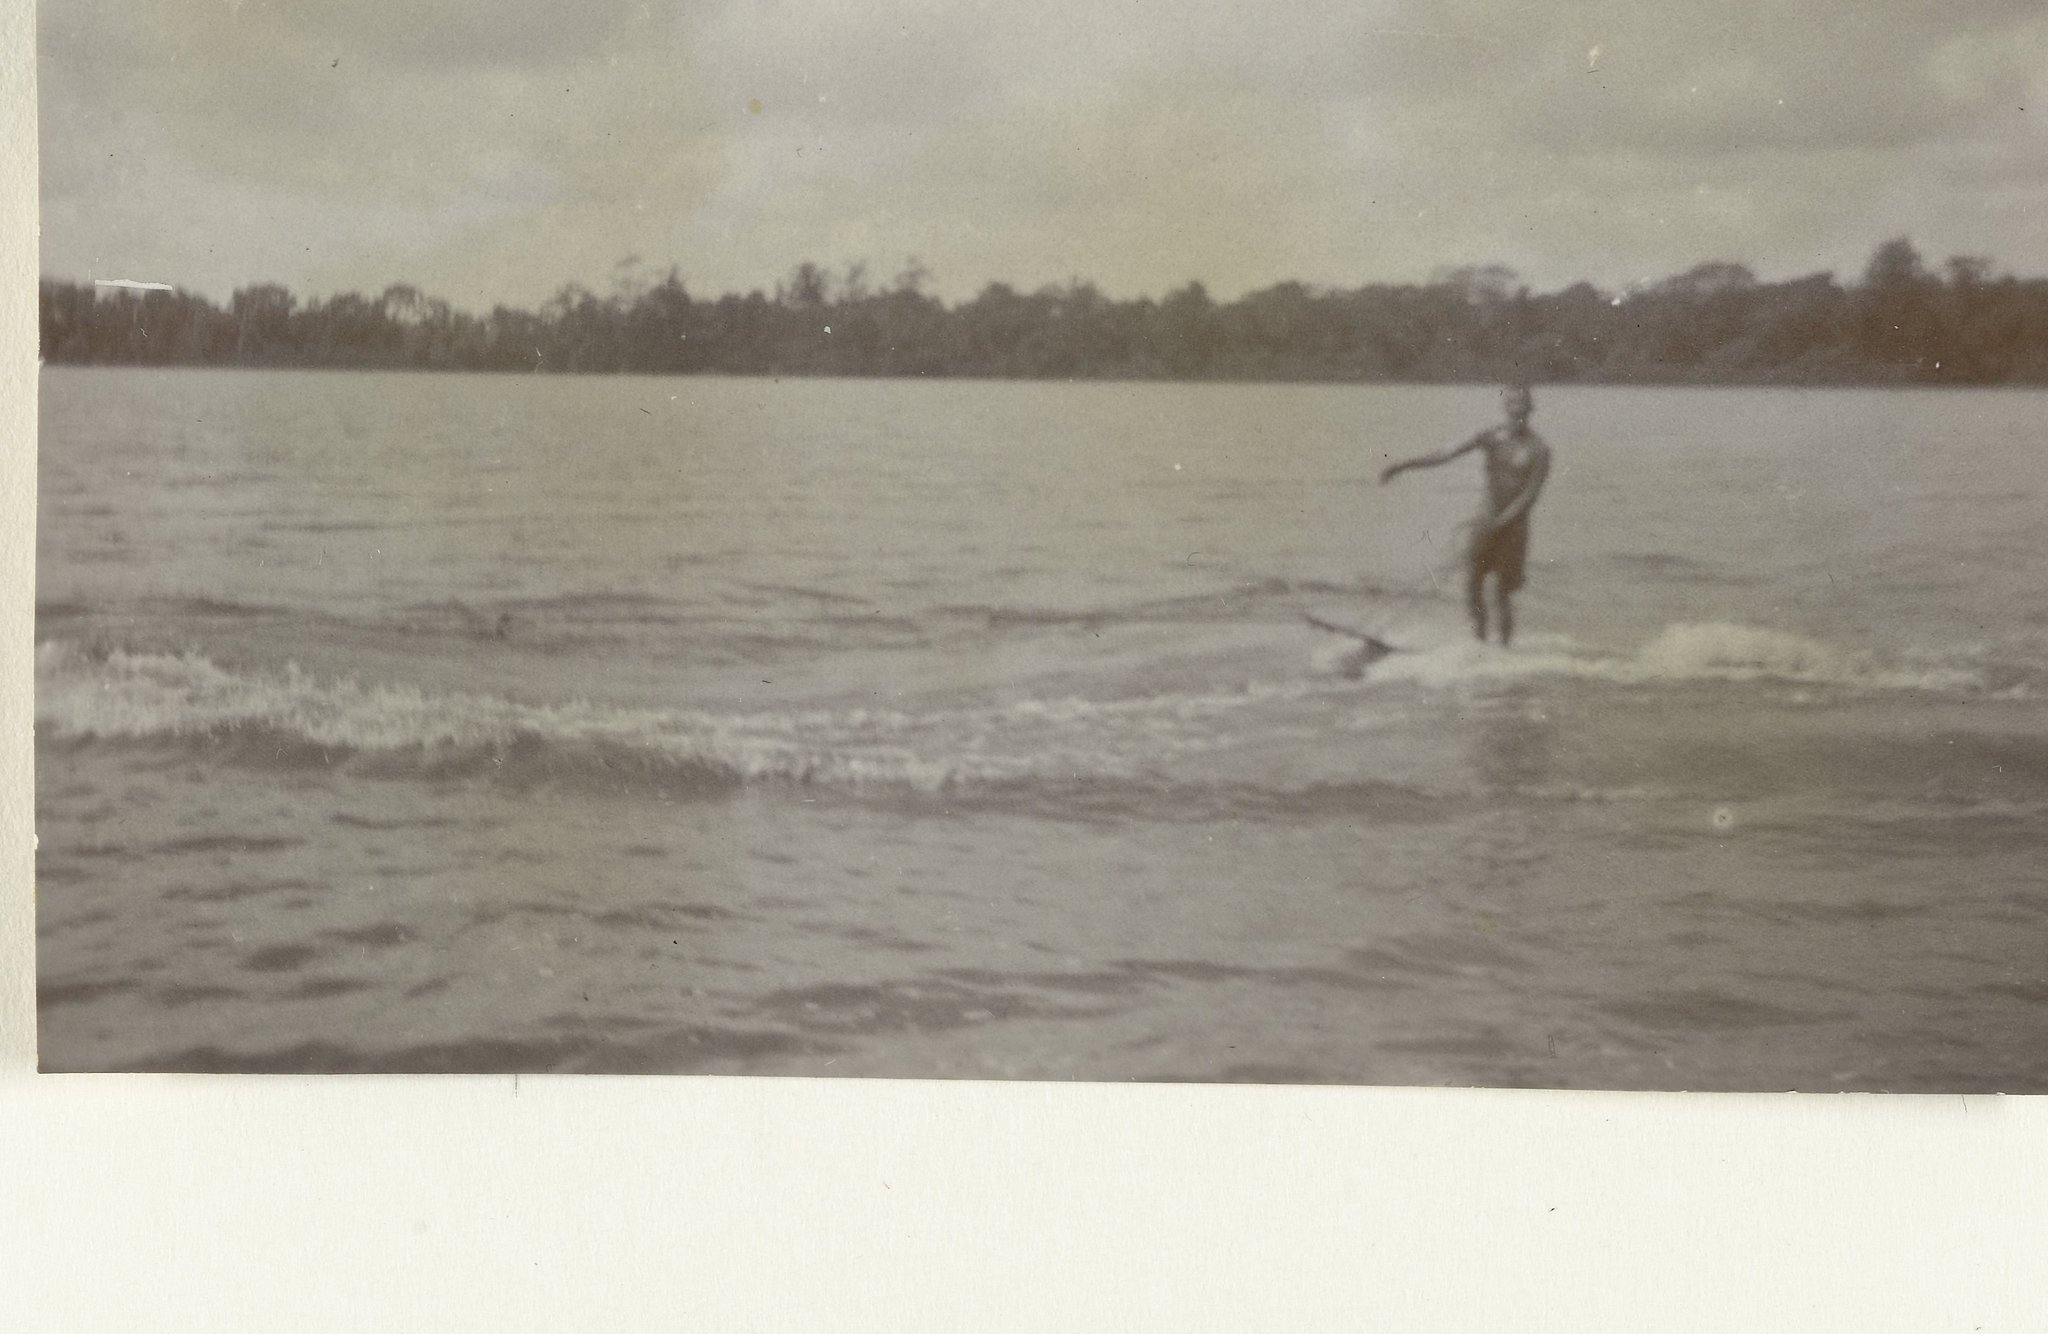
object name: photograph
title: Rivier op plantage Accaribo te Suriname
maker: theodoor brouwers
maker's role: amateurfotograaf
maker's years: 1874-1932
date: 1916-1930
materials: photographic support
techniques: photography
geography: suriname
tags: theodoor brouwers, plantation, suriname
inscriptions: inscription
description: In de periode 1911-1932 woonde op plantage Accaribo in Suriname de familie Brouwers van wie de foto's afkomstig zijn. Rond 1910 vond Theodoor Brouwers werk op plantage Accaribo. In 1929 werd hij eigenaar van de plantage.